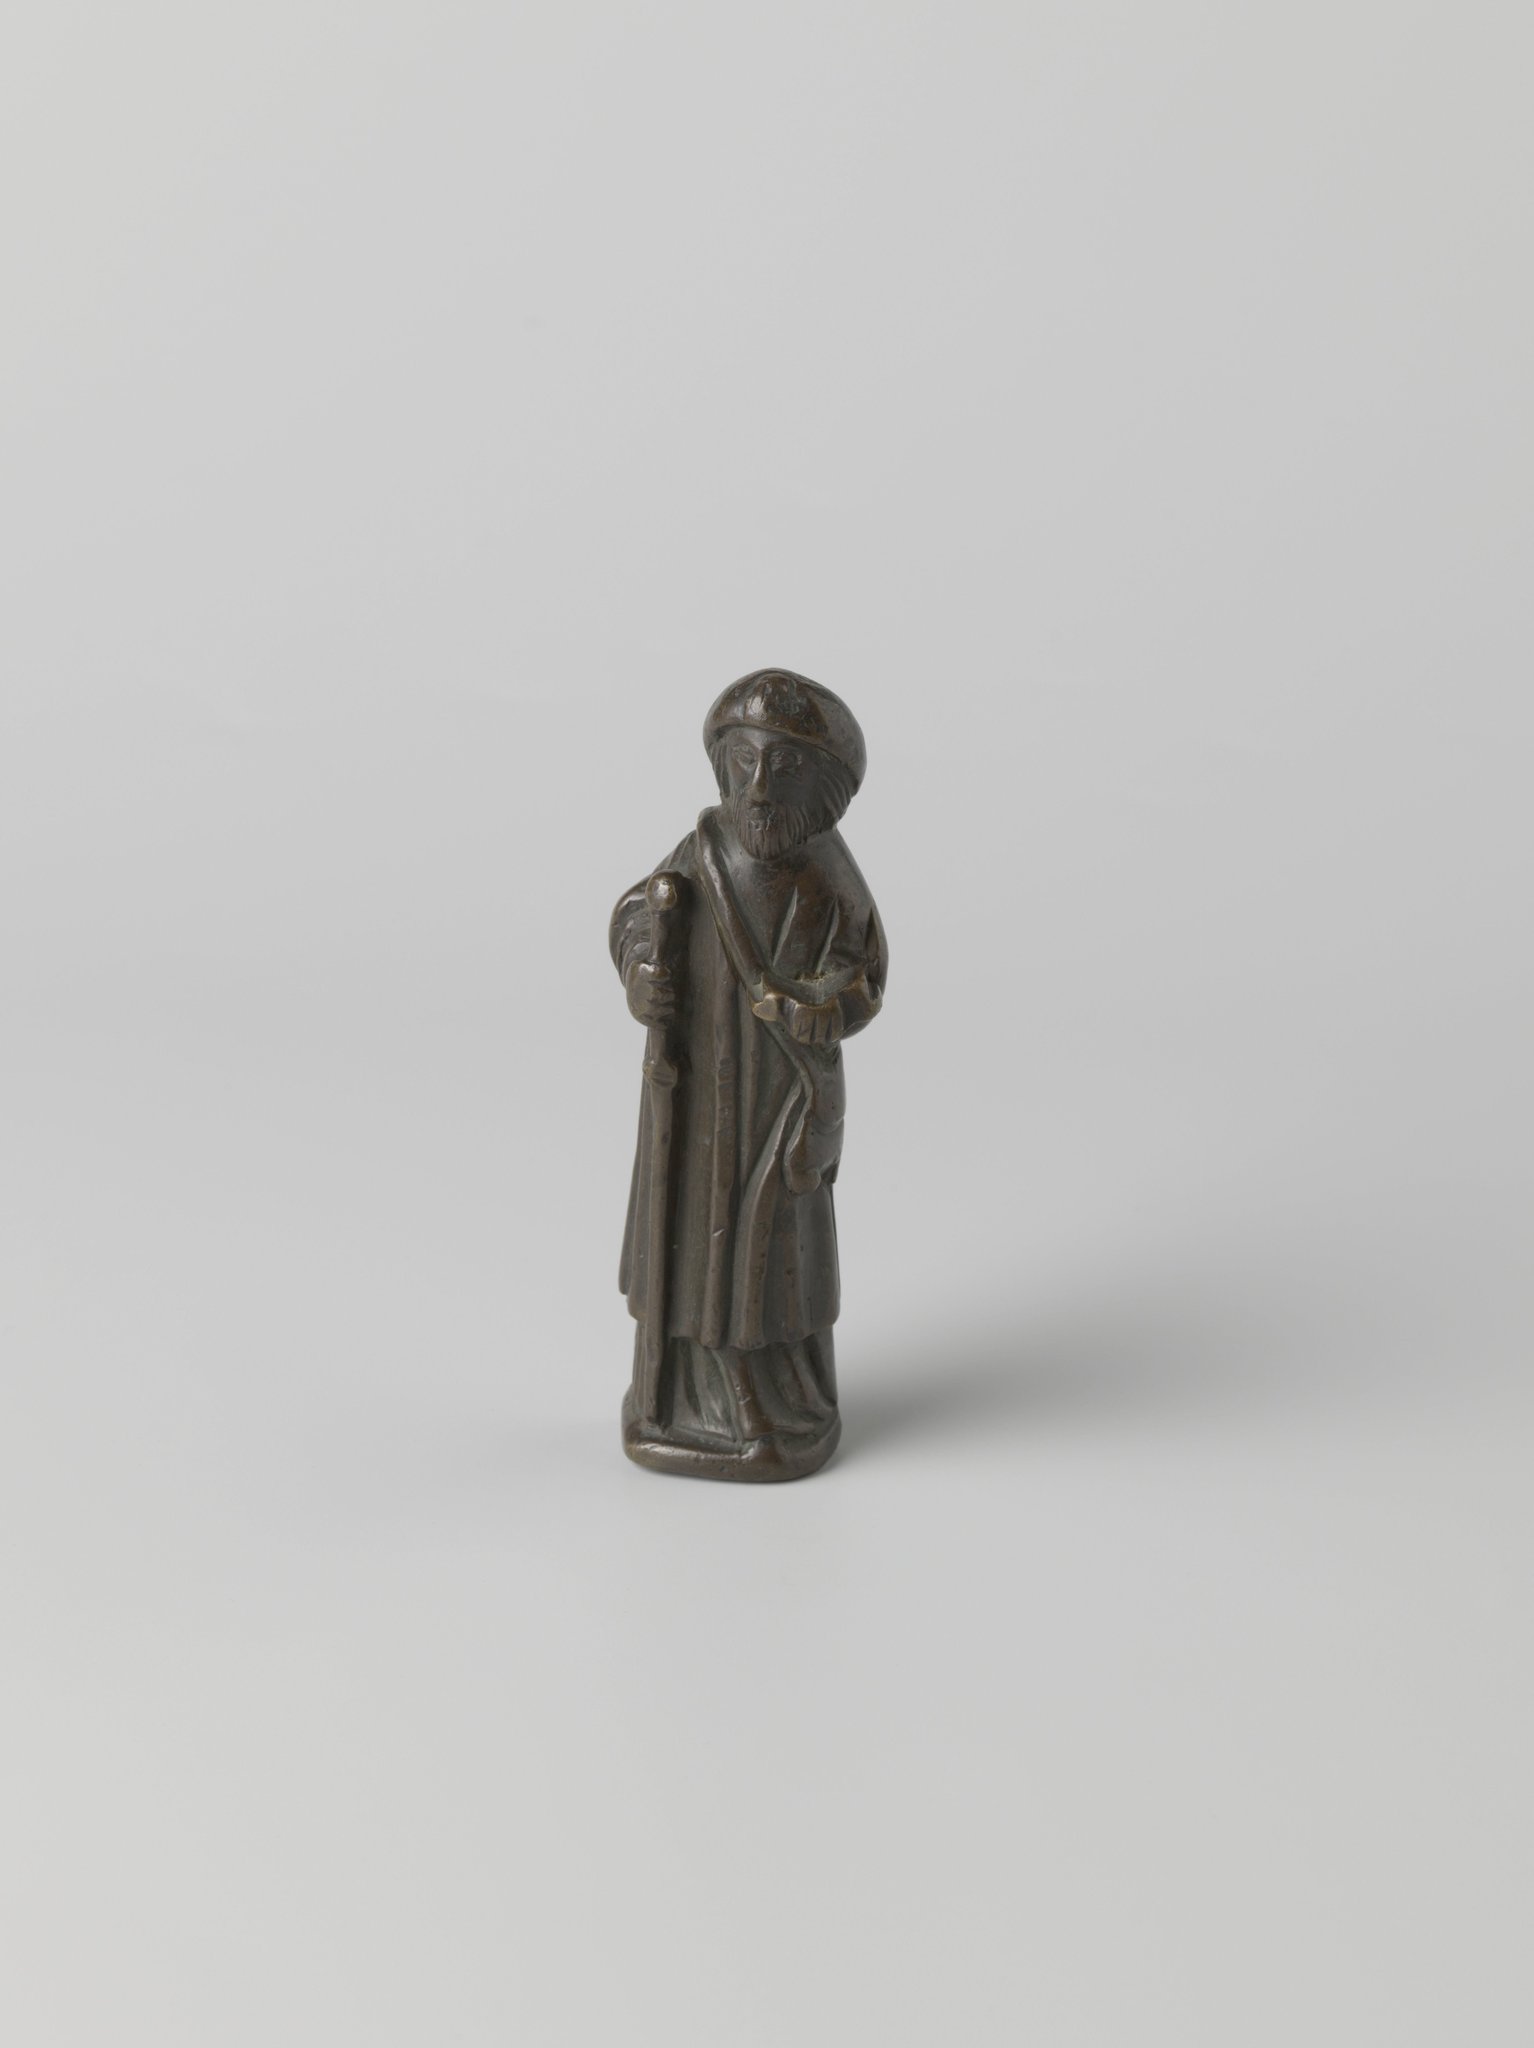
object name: figure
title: Jacobus de Meerdere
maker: Anonymous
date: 1450-1550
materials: brass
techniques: casting, metalworking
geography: southern netherlands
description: De figuur is als één geheel gegoten en hier en daar bijgeciseleerd. Hij is aan de achterkant hol met in het midden een uitsteeksel ter bevestiging aan een groter voorwerp. De heilige is te herkennen aan de pelgrimskleding, een staf, een boek en een met een schelp versierde hand.